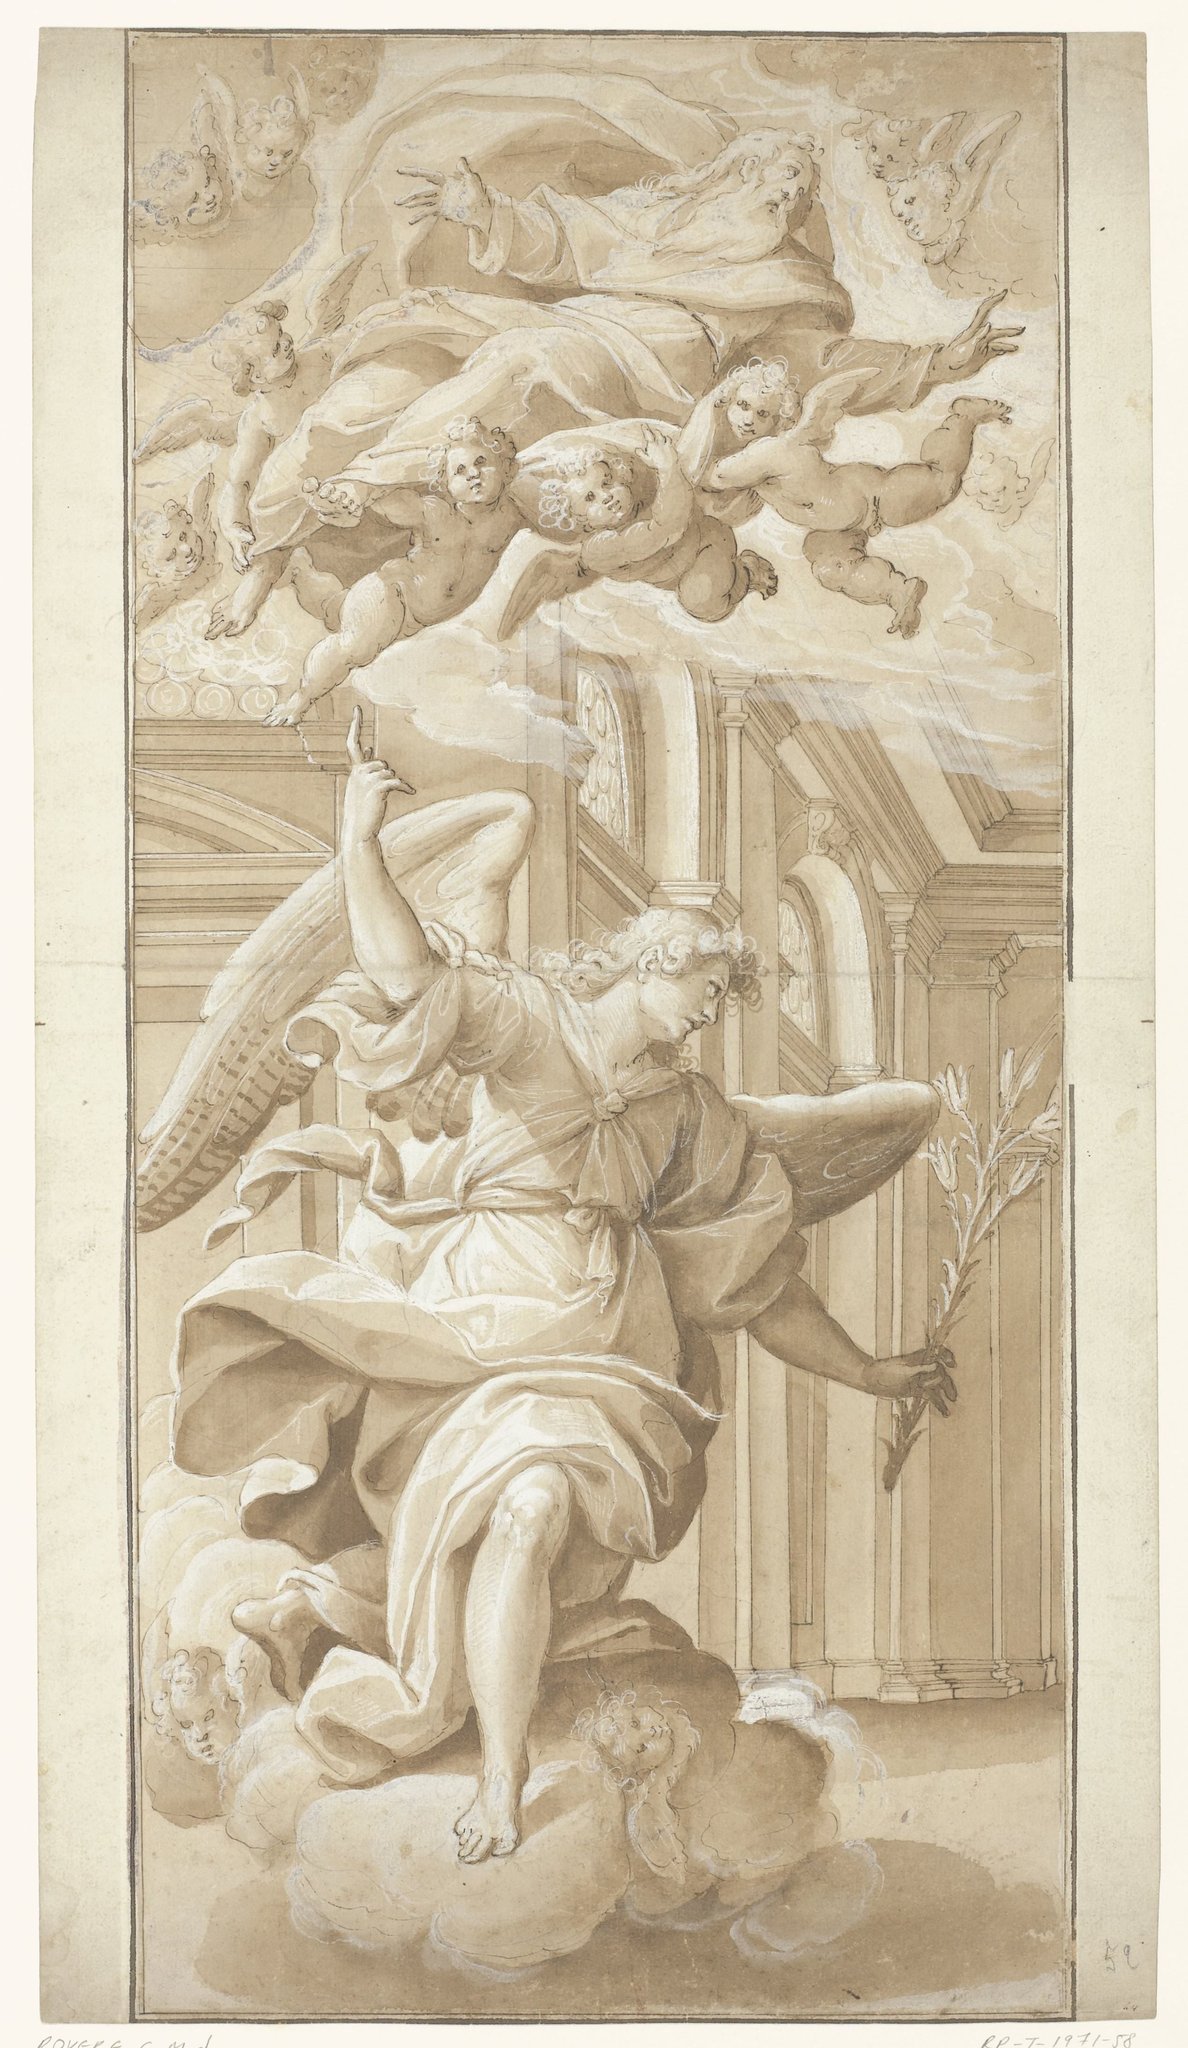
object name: drawing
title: Verkondigingsengel, op wolken tredend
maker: giovanni mauro della rovere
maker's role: draughtsman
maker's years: 1575-1640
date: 1585-1640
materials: chalk, ink, paint, paper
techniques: brush, pen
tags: the archangel gabriel, the announcement of christ's birth (luke 1:26-38)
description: Verkondigingsengel, op wolken tredend, in een Renaissance-interieur.